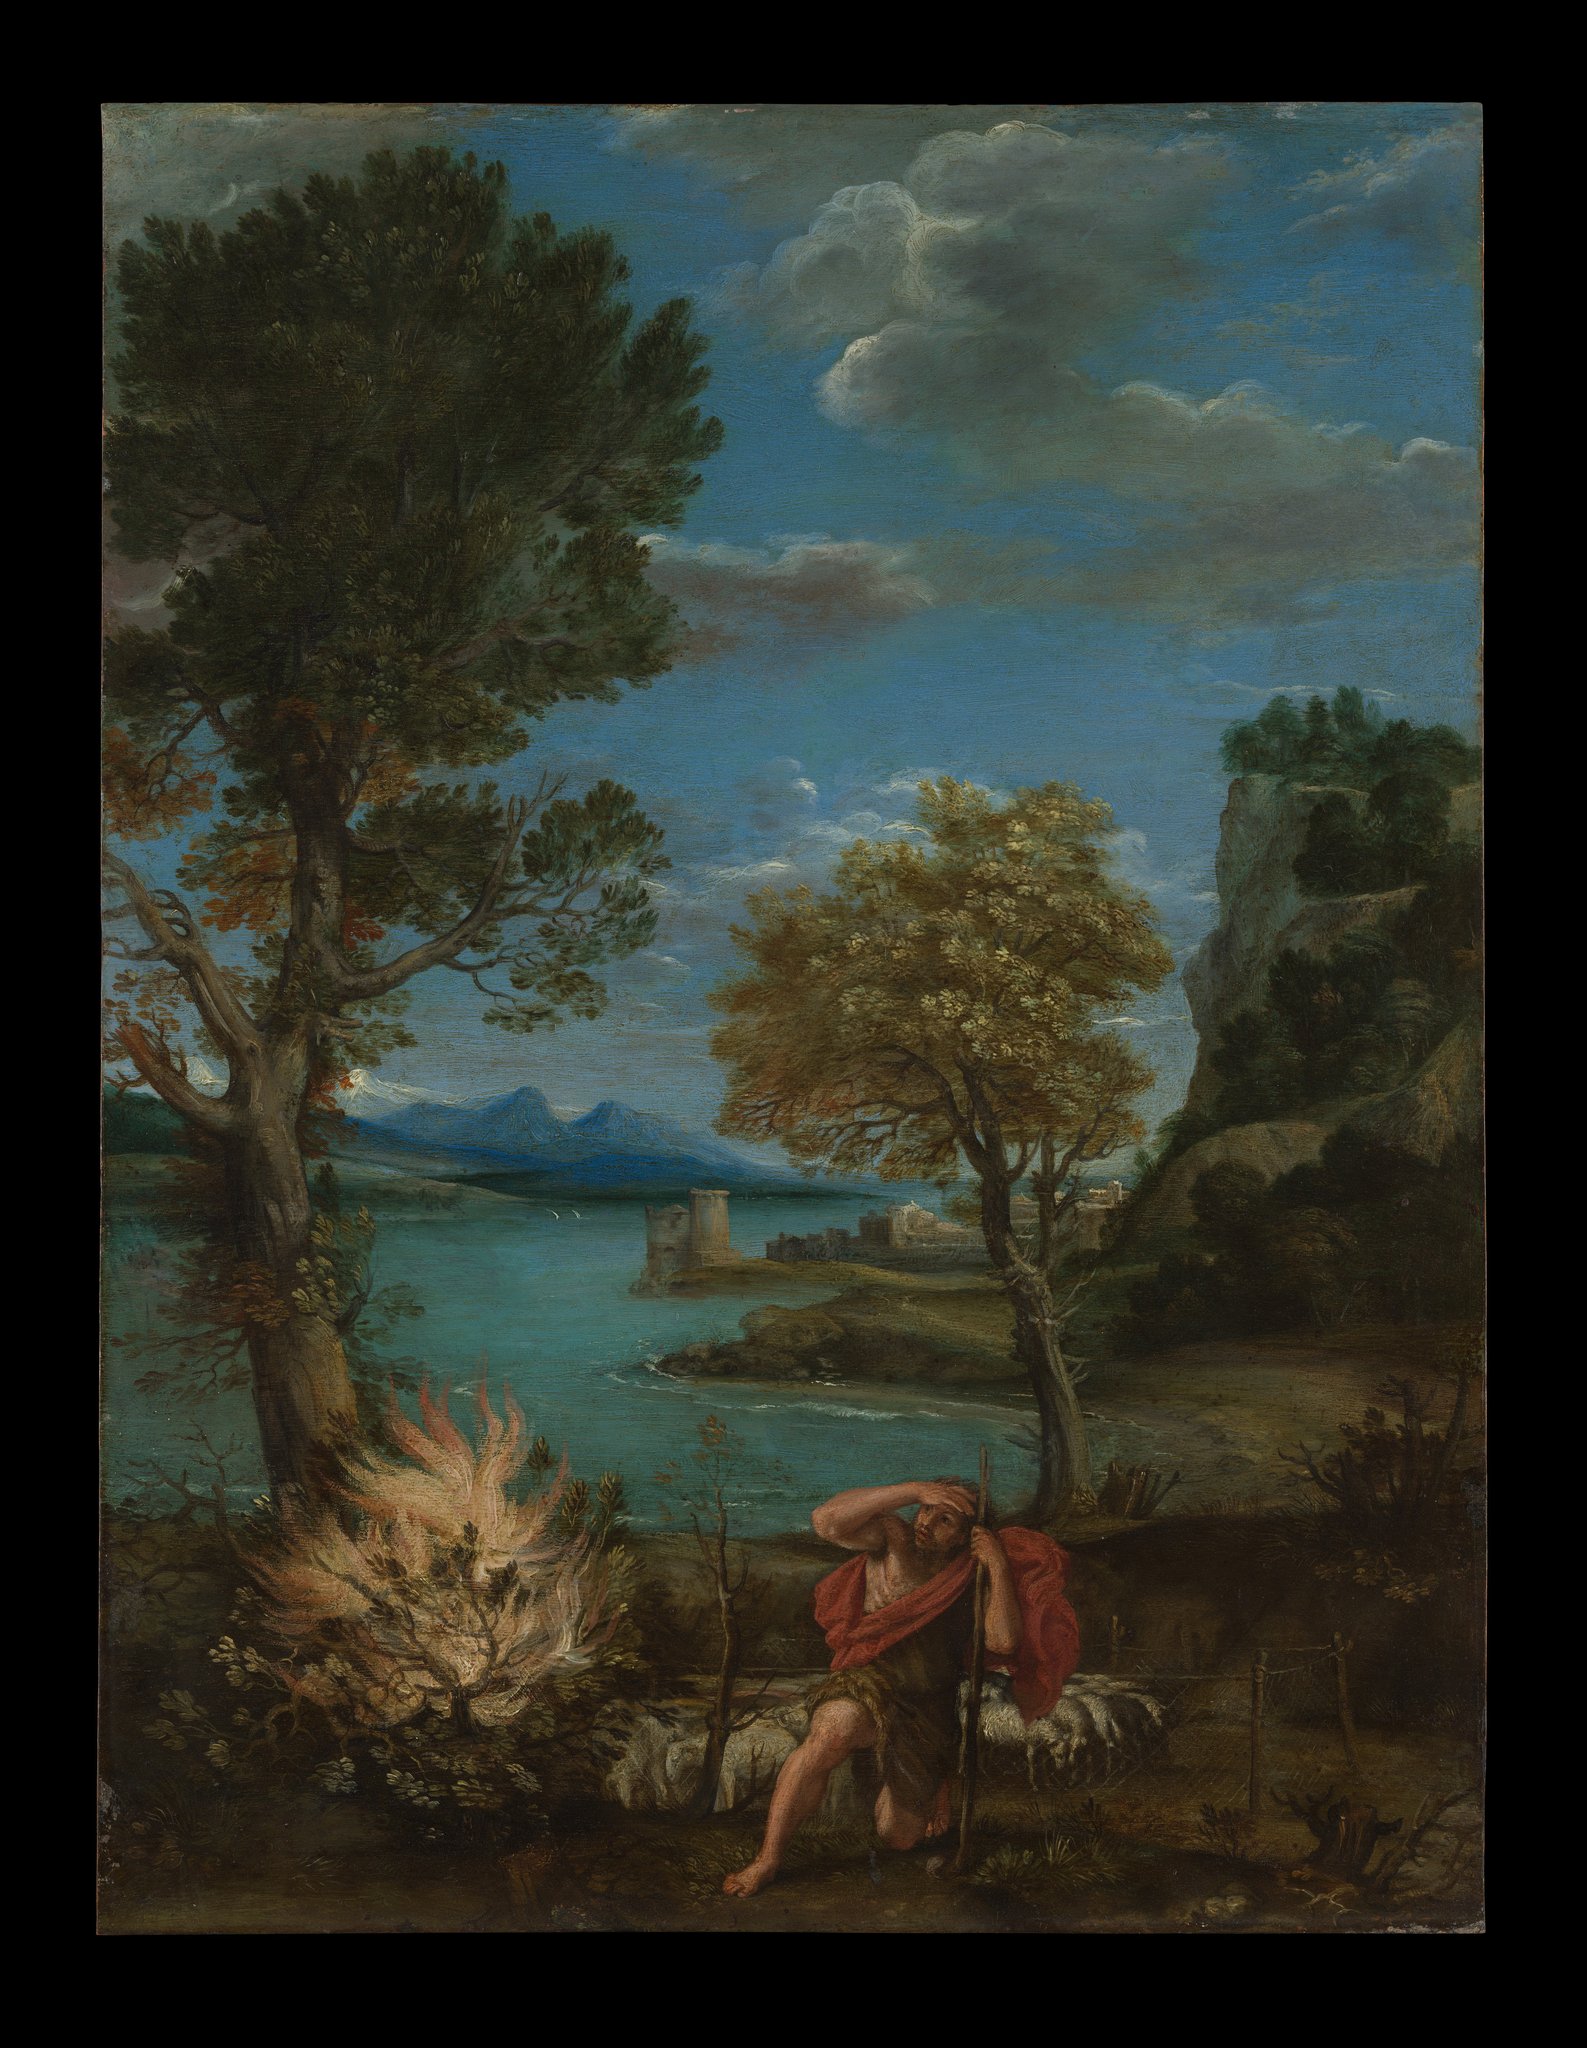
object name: painting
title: Landscape with Moses and the Burning Bush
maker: domenichino (domenico zampieri)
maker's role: artist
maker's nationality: italian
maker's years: 1581-1641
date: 1610-1616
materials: copper, oil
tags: sheep,fire,landscapes,moses